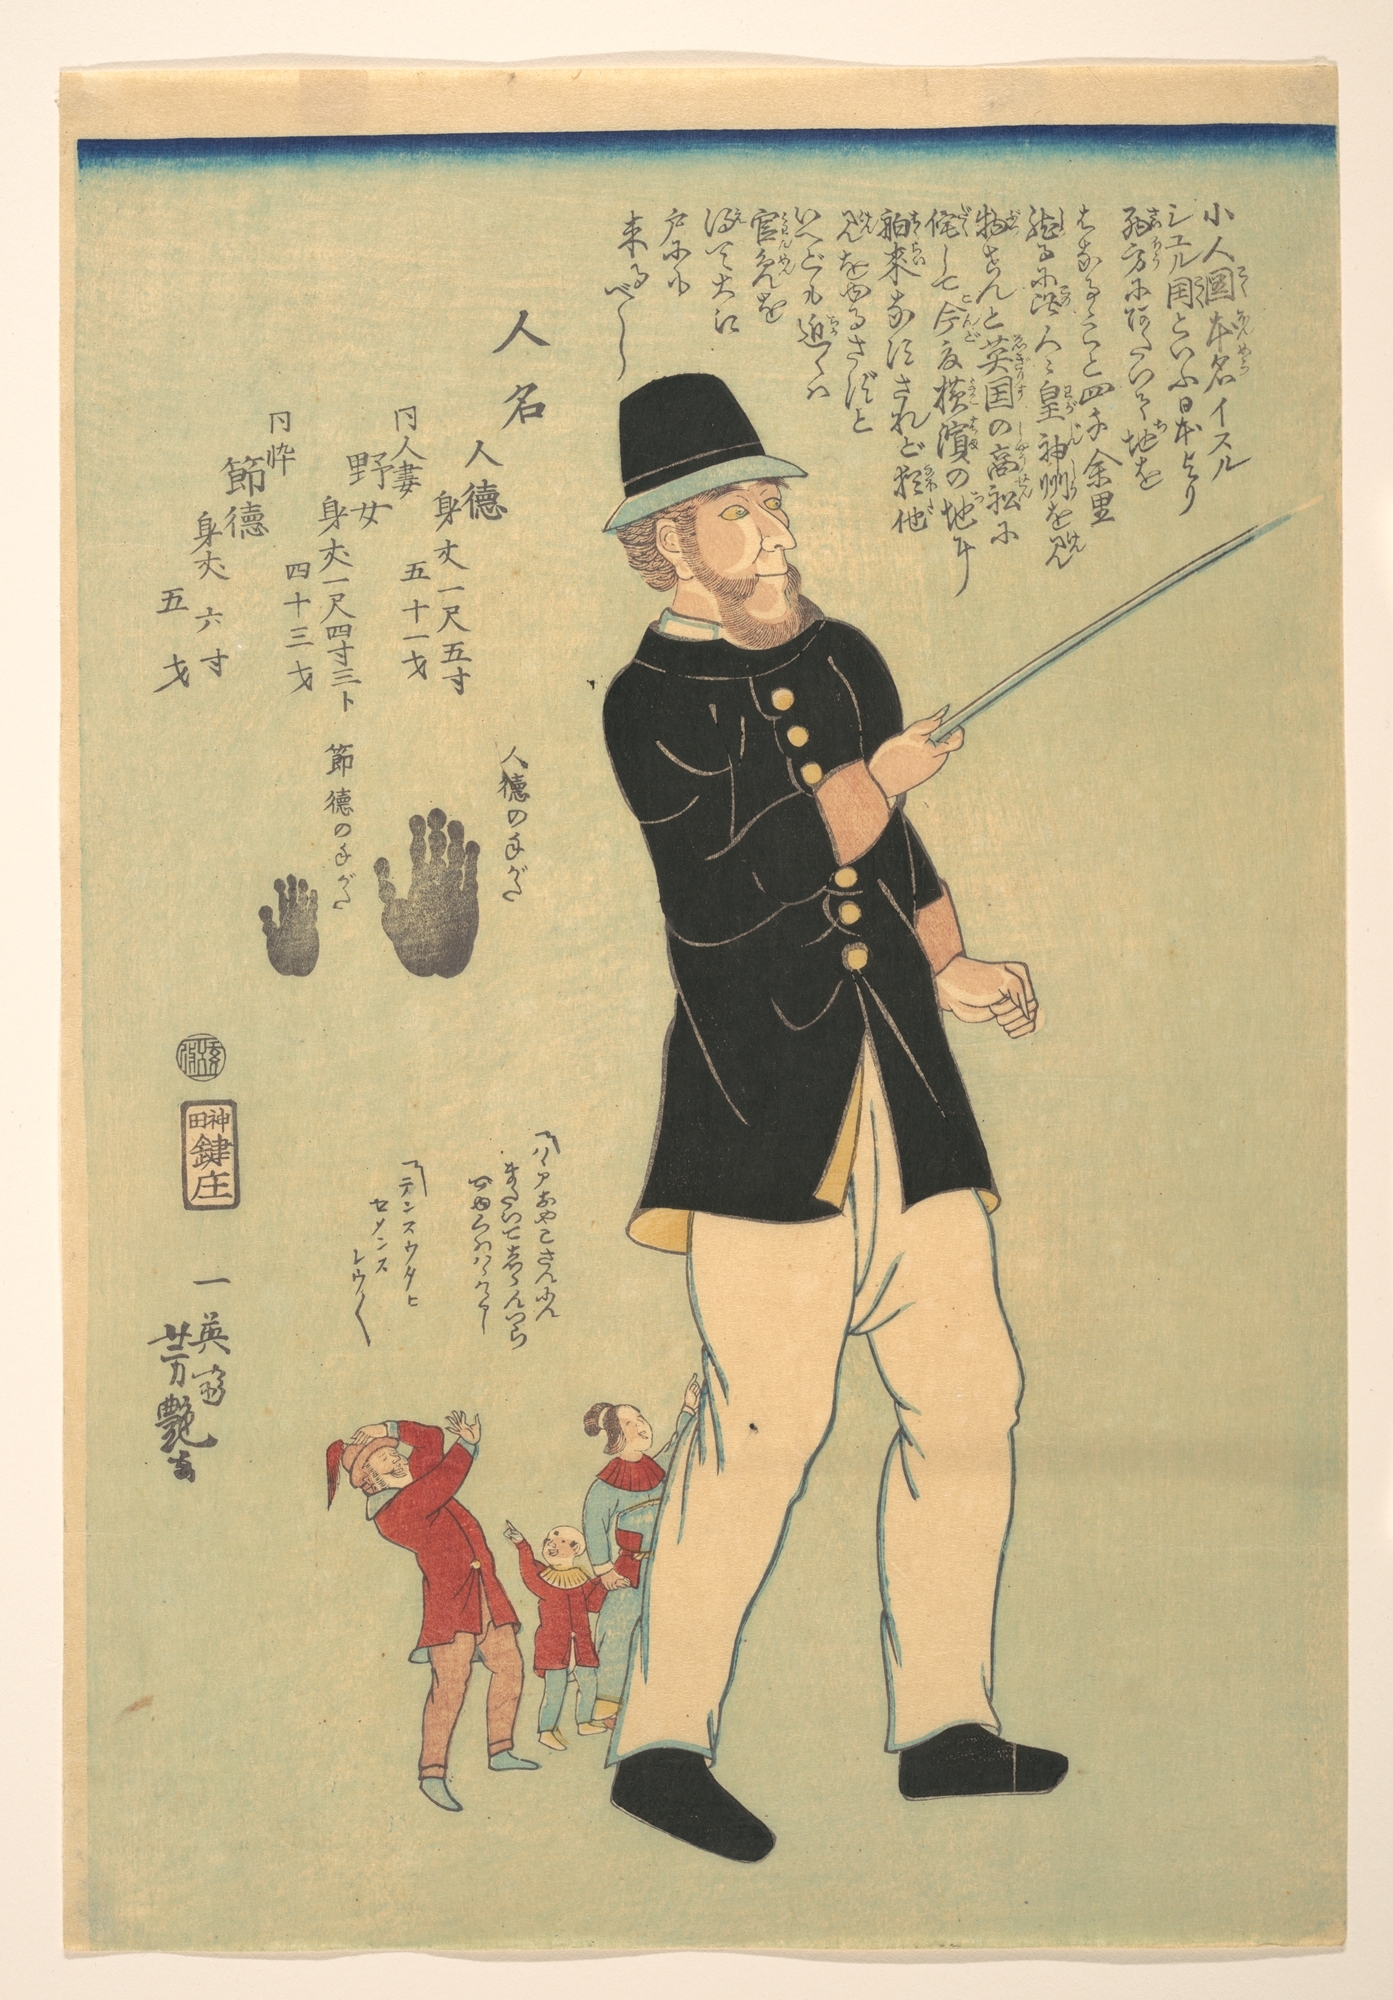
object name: print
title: Foreigner Walking with a Pygmy Family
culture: japanese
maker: utagawa yoshitsuya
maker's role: artist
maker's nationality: japanese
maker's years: 1822-1866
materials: ink, paper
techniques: woodblock print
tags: boys,men,women,family